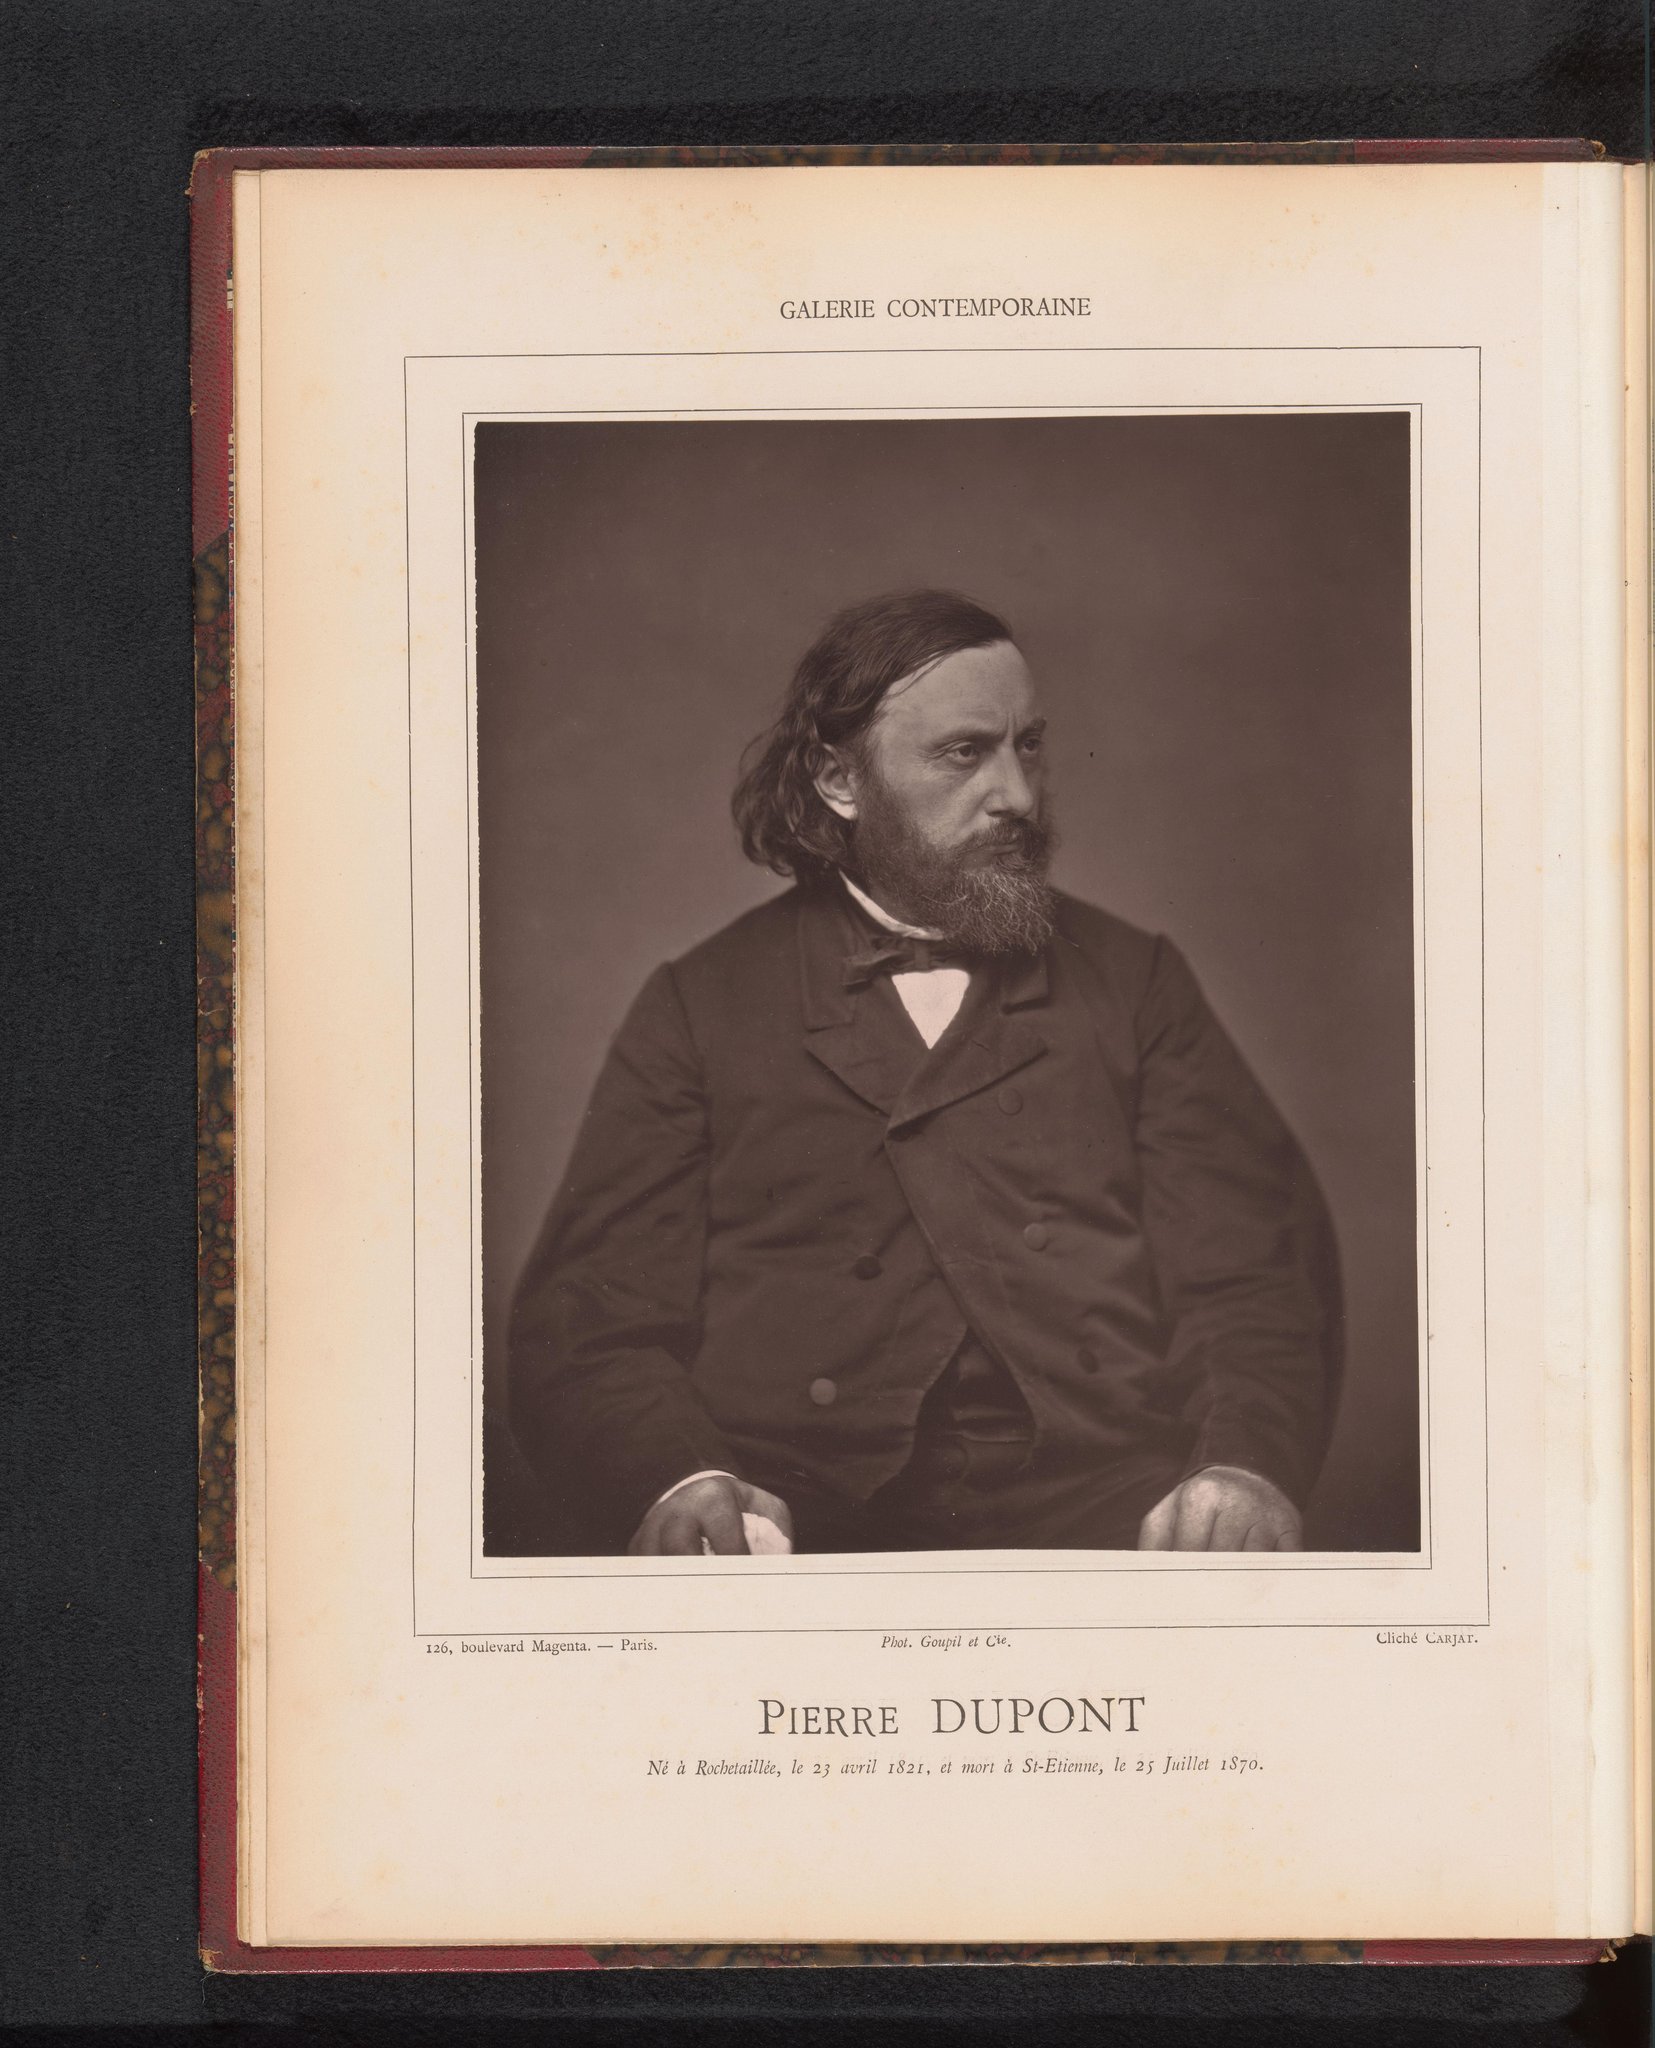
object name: photomechanical print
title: Portret van Pierre Dupont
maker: étienne carjat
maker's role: draughtsman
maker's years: 1828-1906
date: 1865-1870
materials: paper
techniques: woodburytype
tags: lyon, adult man, historical persons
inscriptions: inscription: ‘Galerie Contemporaine, 126, boulevard Magenta. - Paris./ Né à Rochetaillée, le 23 avril 1821, et mort à St-Etienne, le 25 Juillet 1870.’